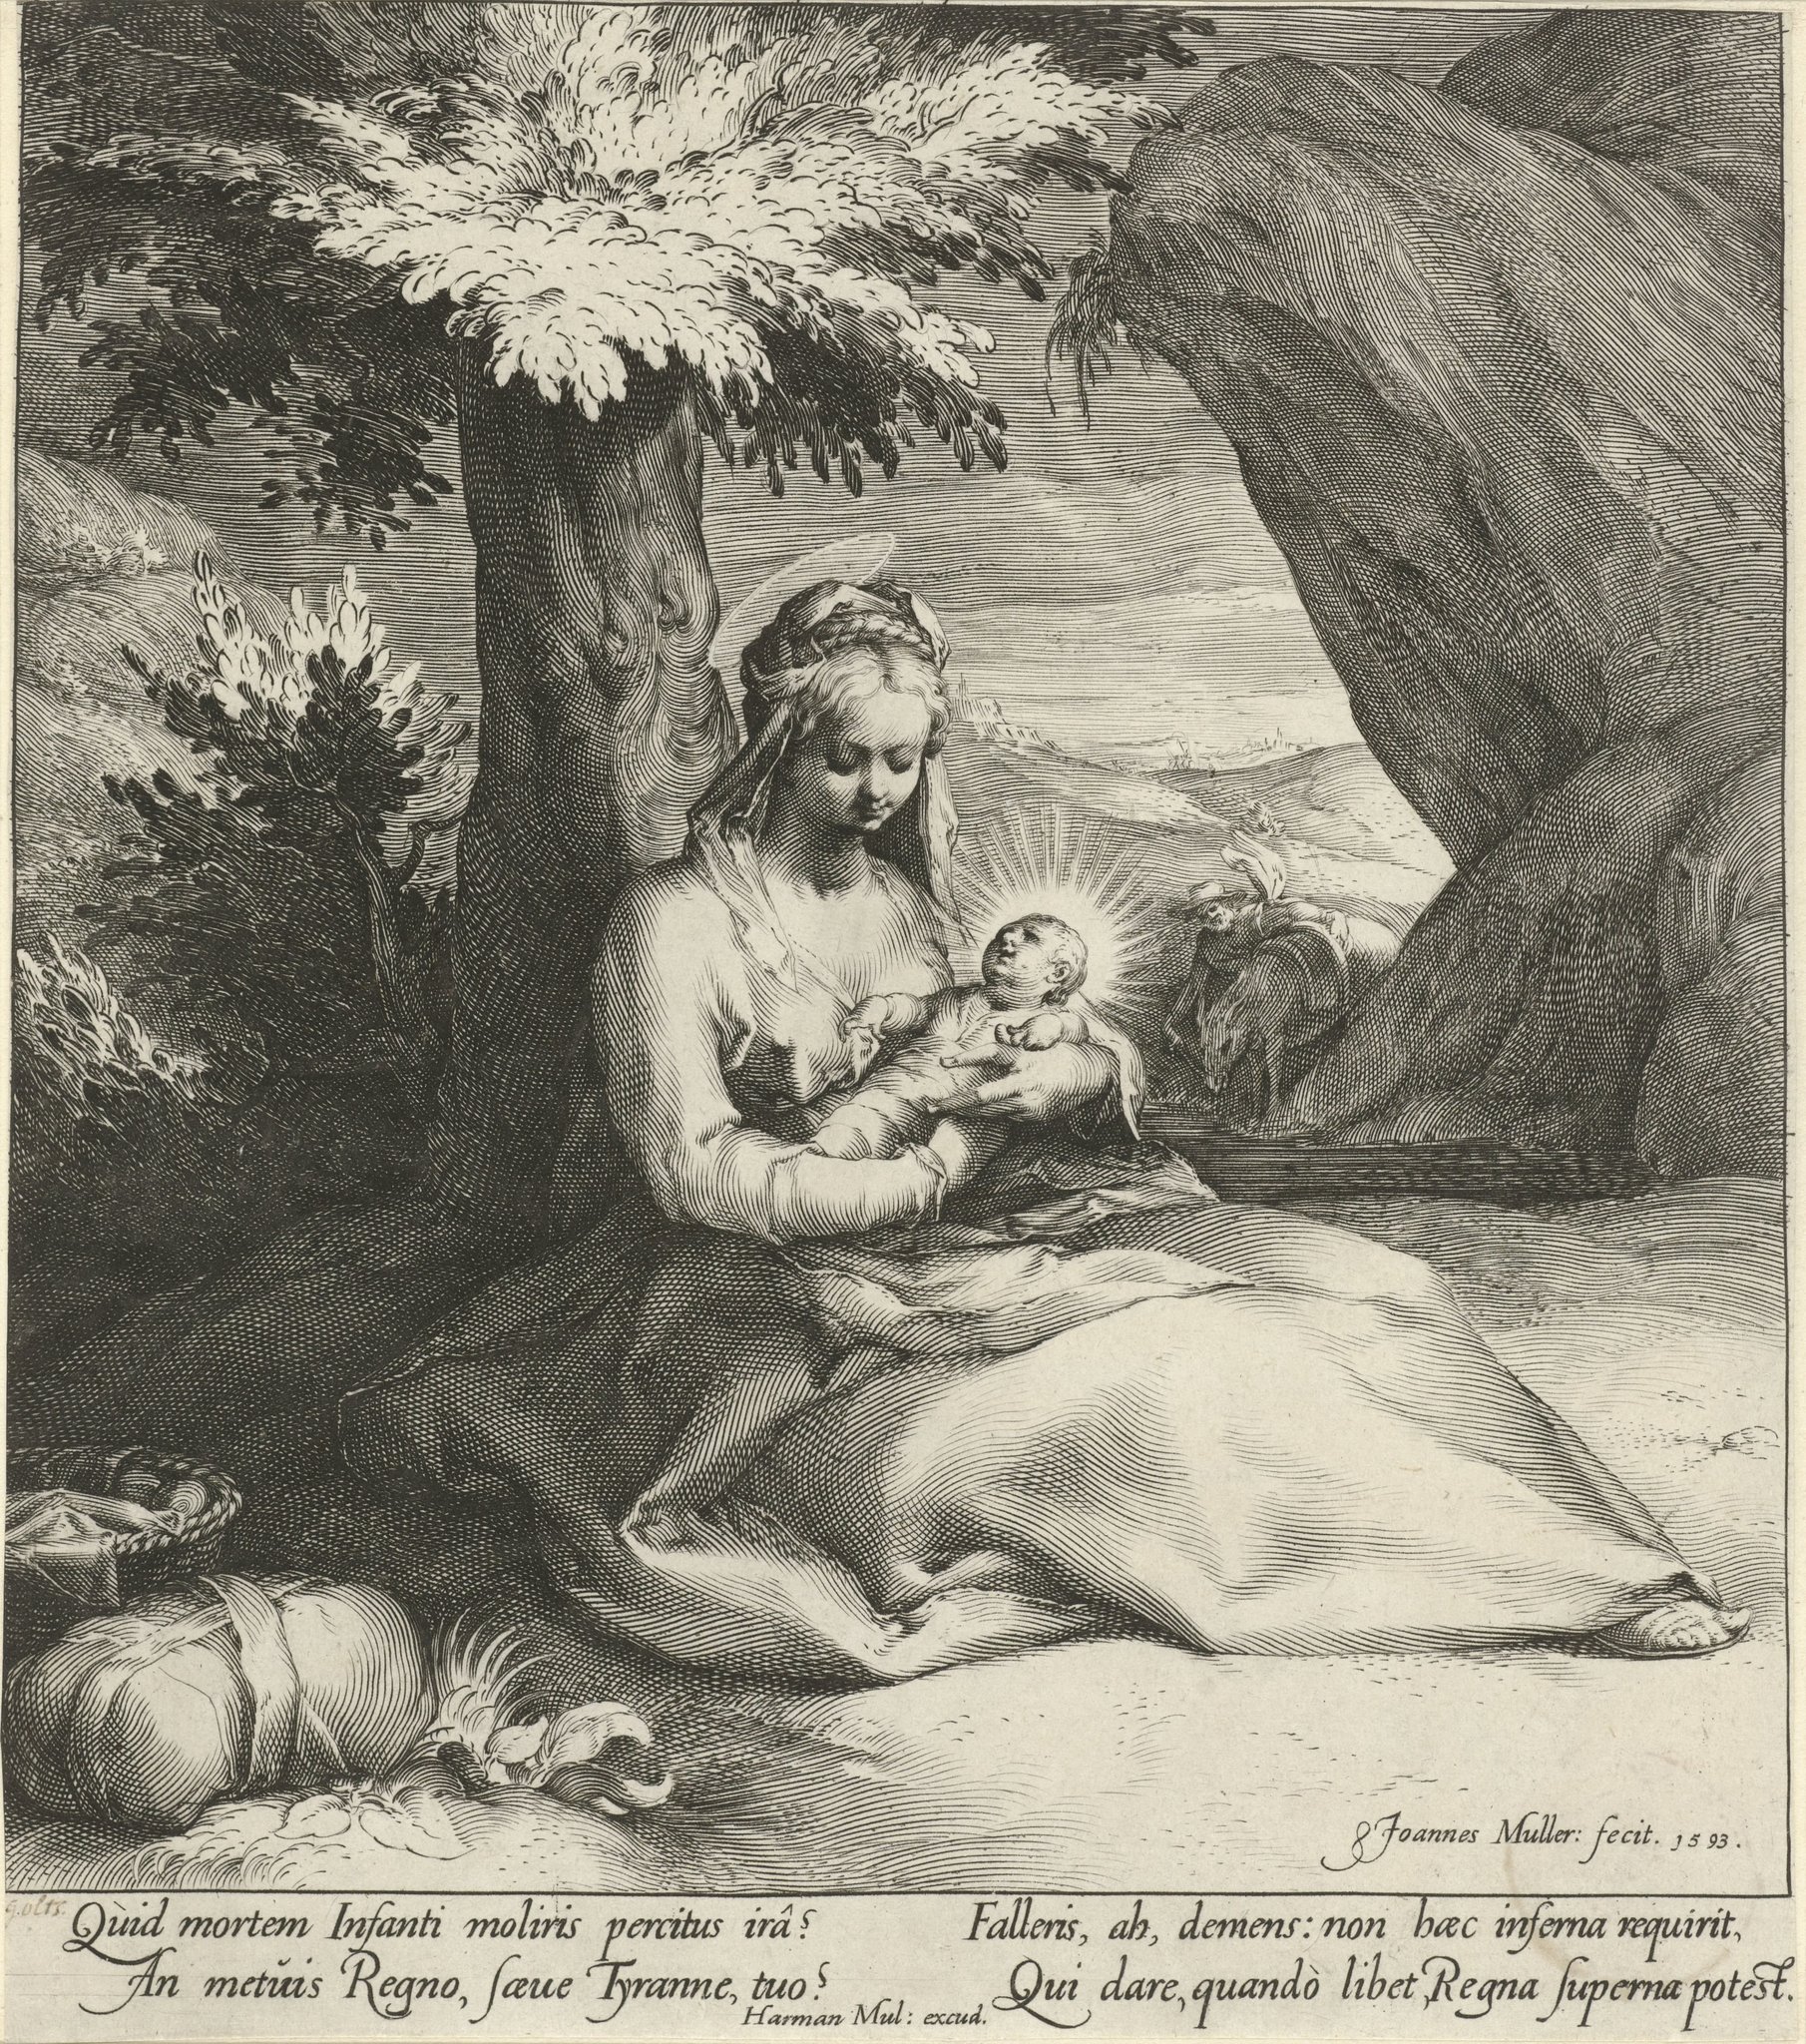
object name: print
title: Rest on the Flight into Egypt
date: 1593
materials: paper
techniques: engraving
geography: amsterdam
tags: rest on the flight into egypt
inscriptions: collector's mark: Lugt 240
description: Maria rust, met het Christuskind in haar armen, onder een boom. Op de achtergrond verschijnt Jozef met de ezel vanachter een rots. Onderaan in de marge een tekst in het Latijn.